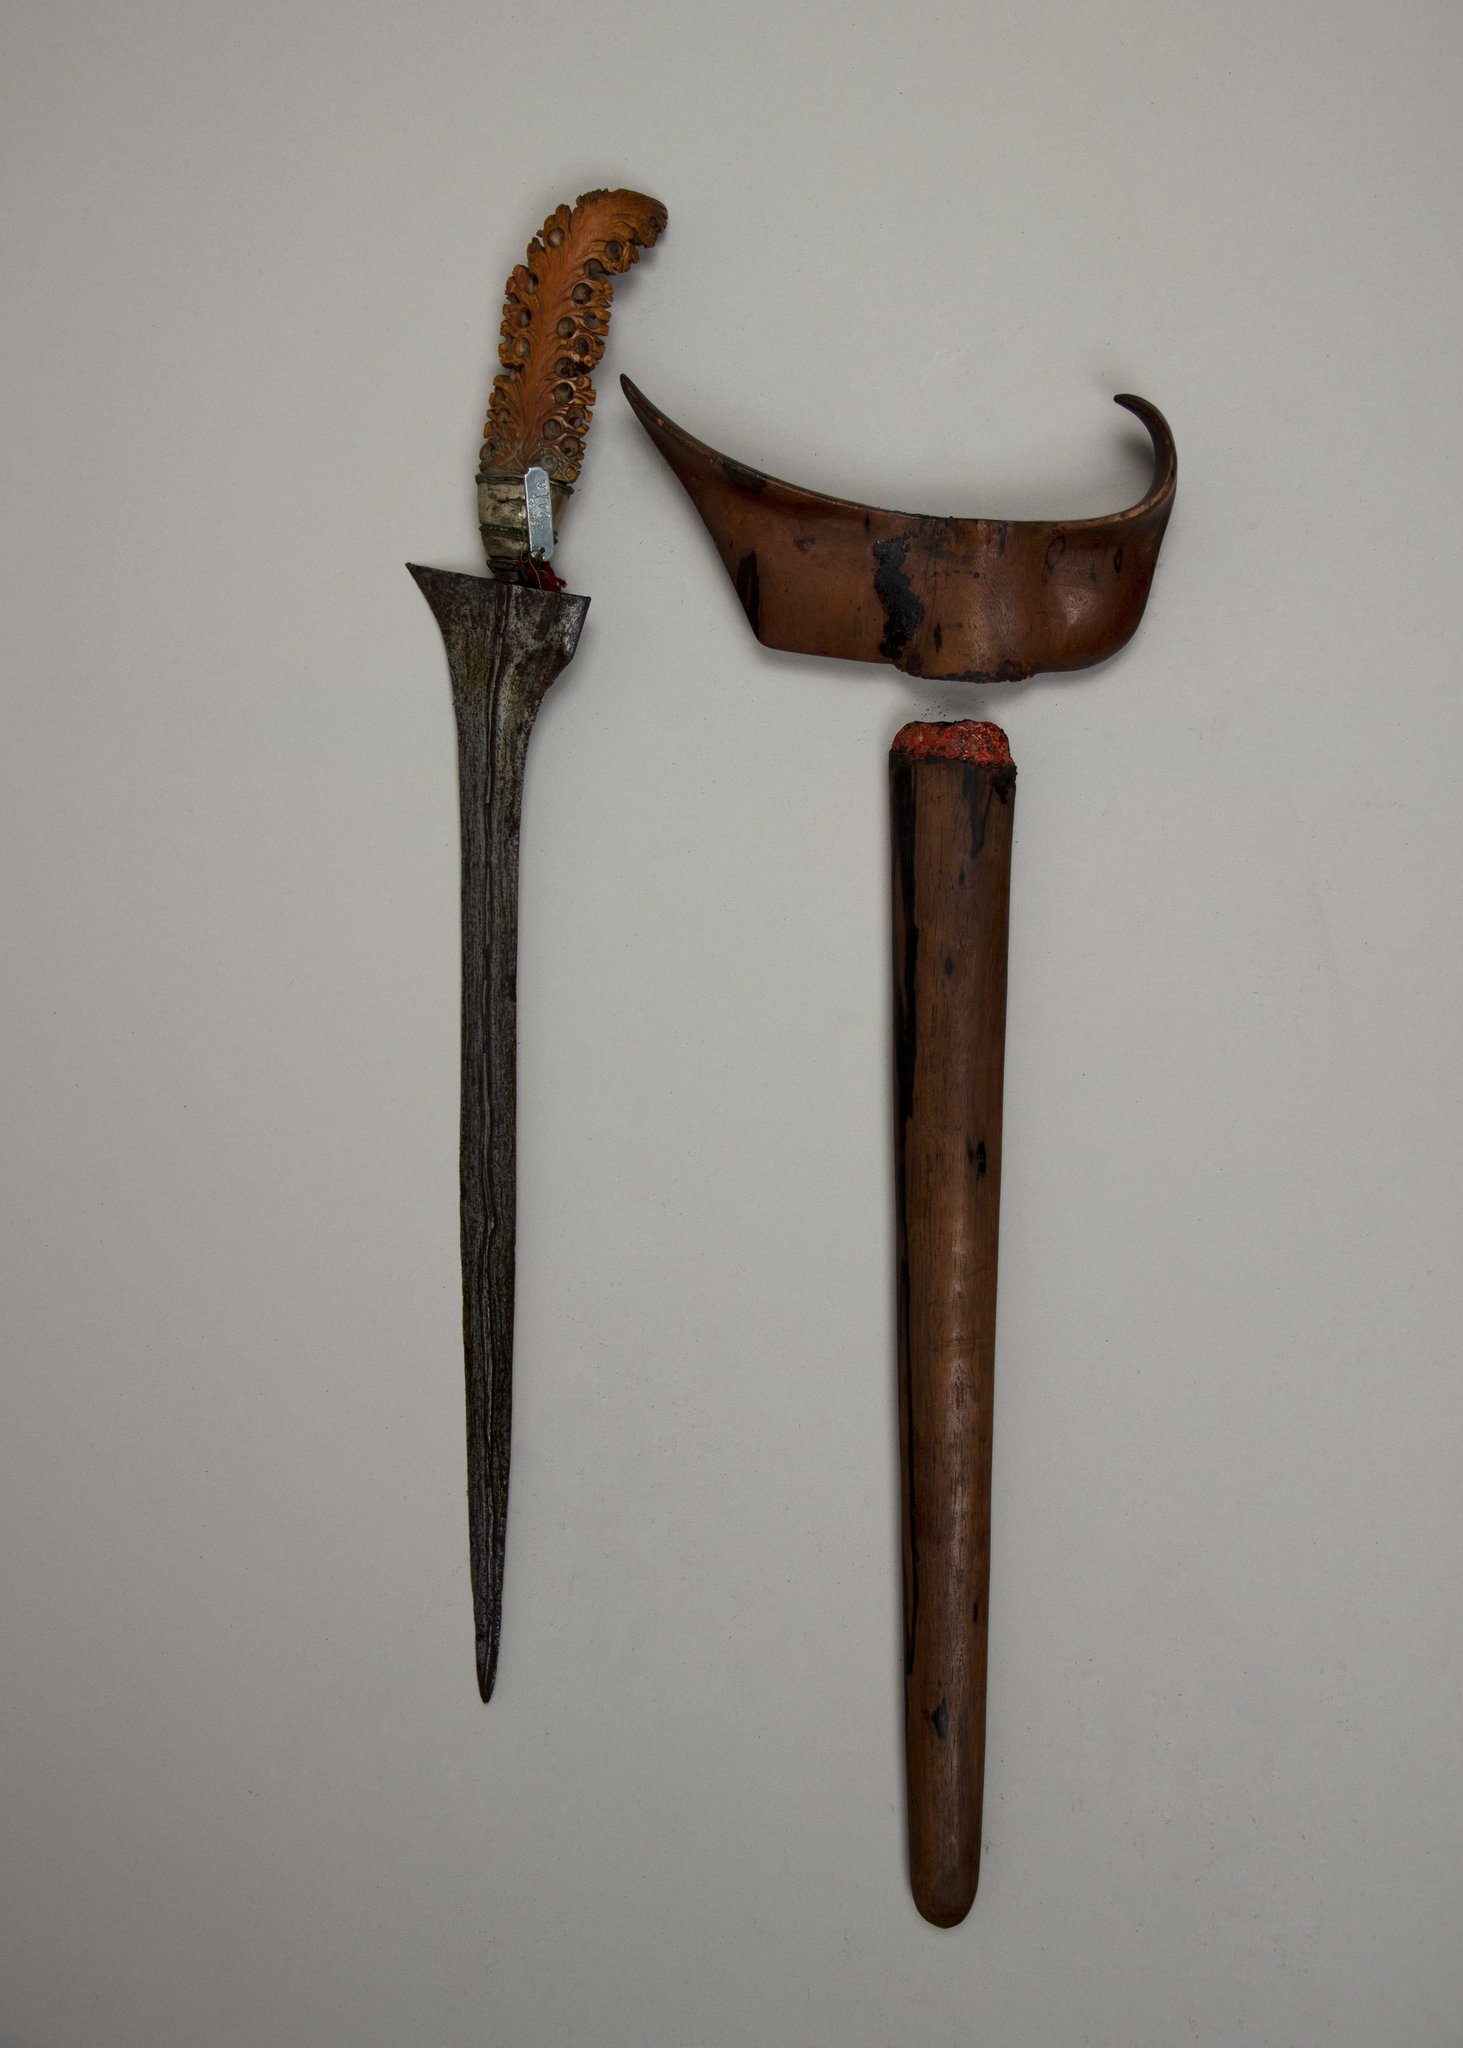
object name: kris with sheath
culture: javanese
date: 1501-1900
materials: horn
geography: indonesia